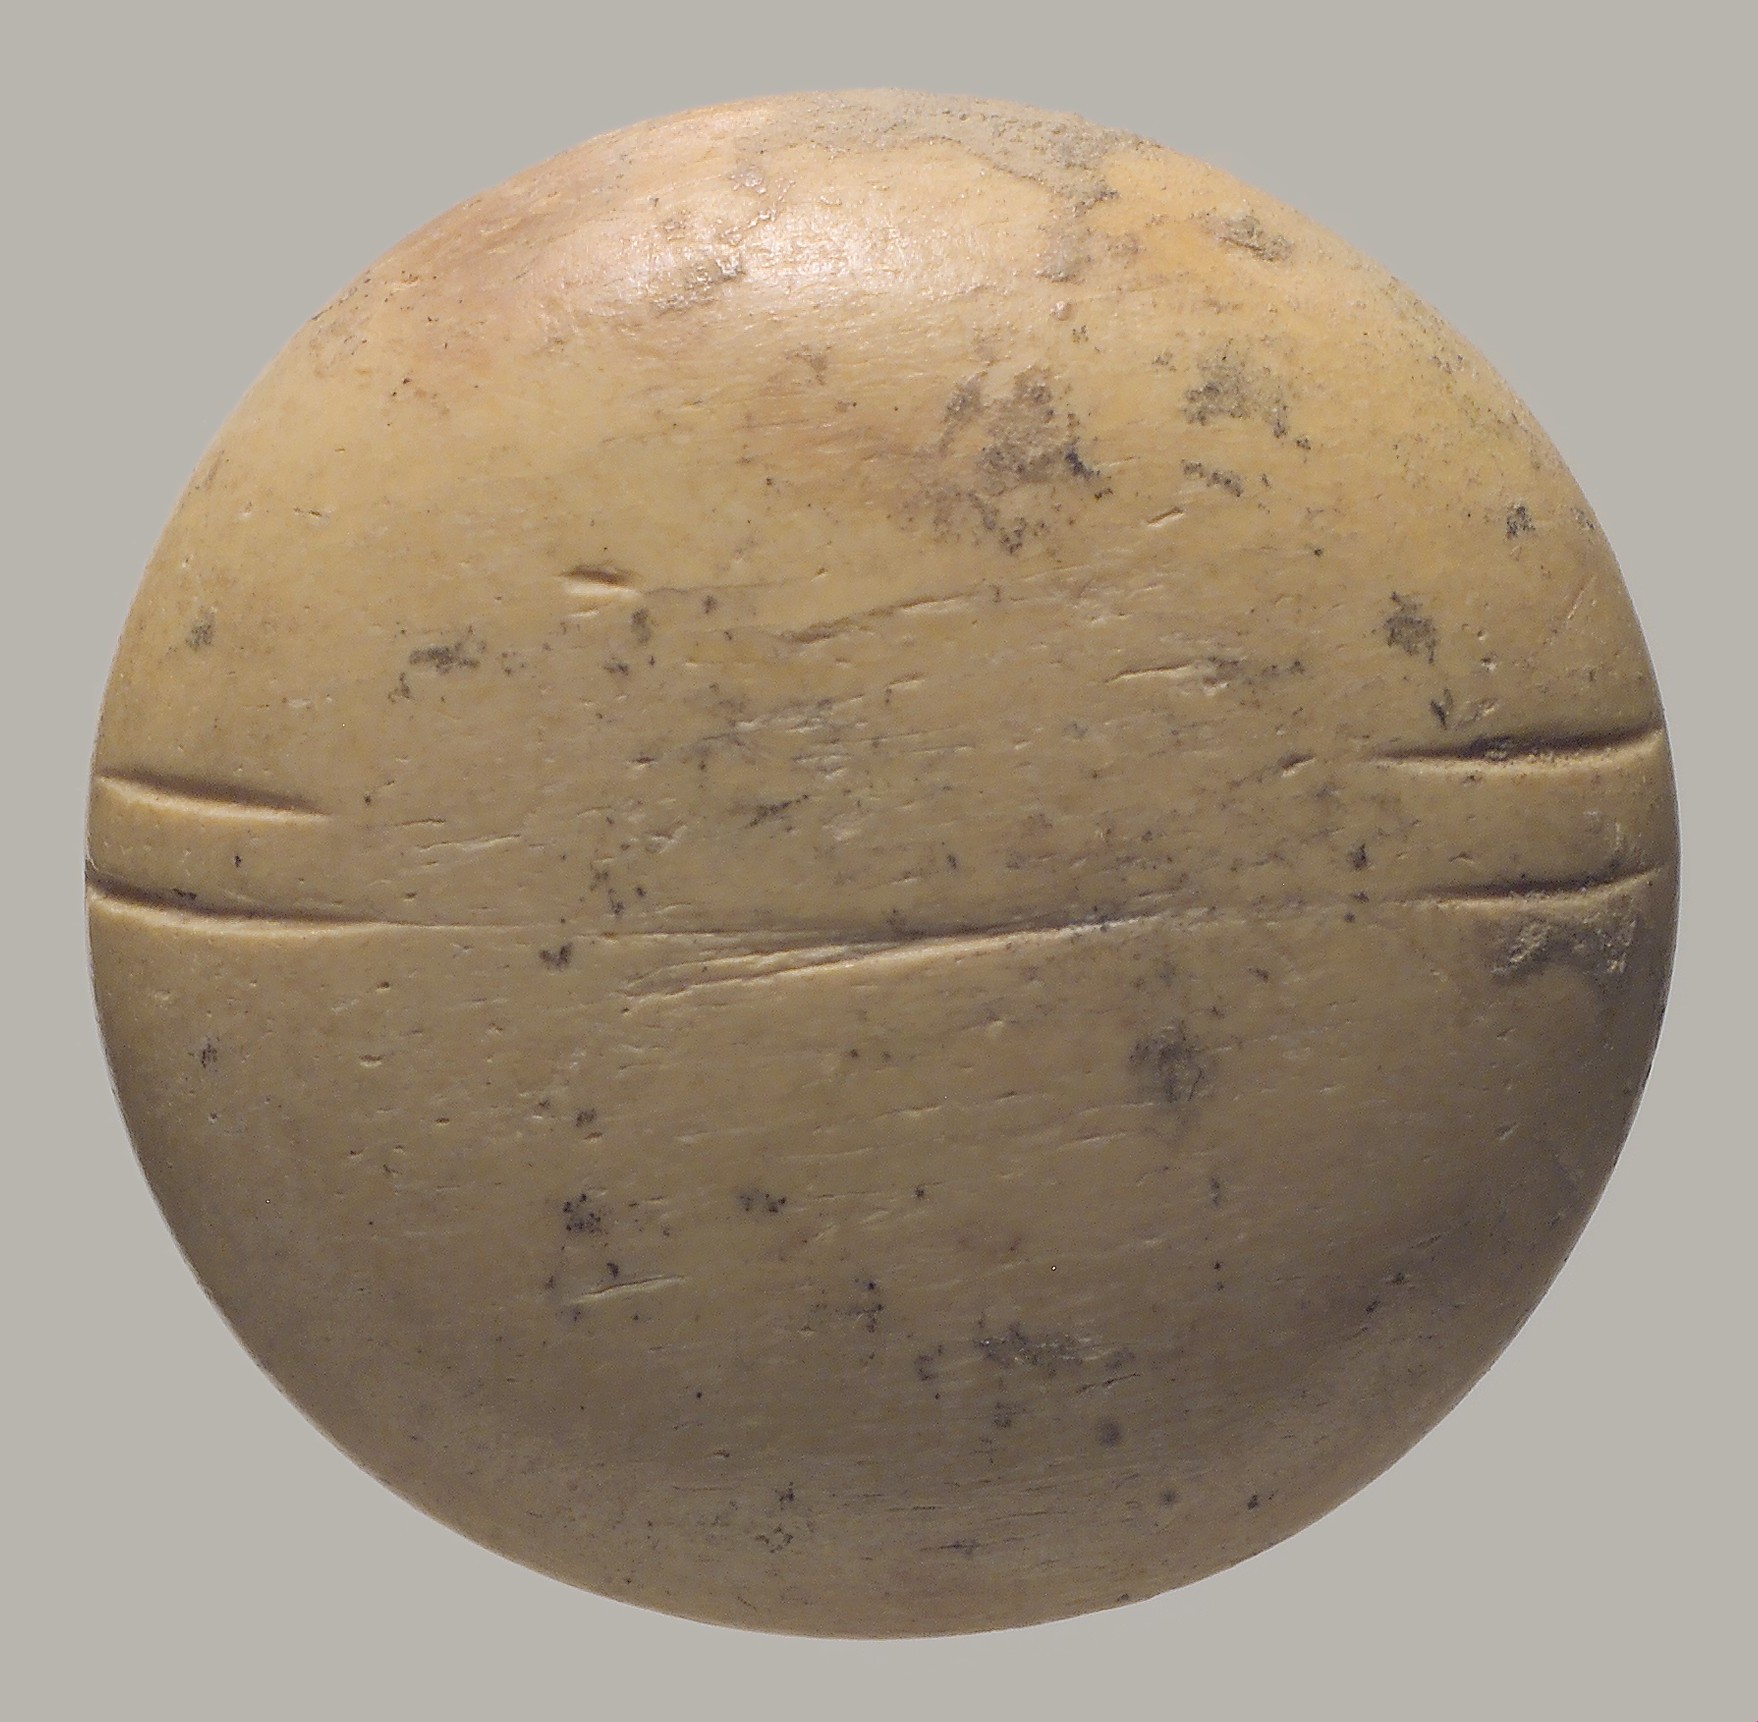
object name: disc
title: Disc: die or gaming piece (?)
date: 3000-1001 BCE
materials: bone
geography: mesopotamia